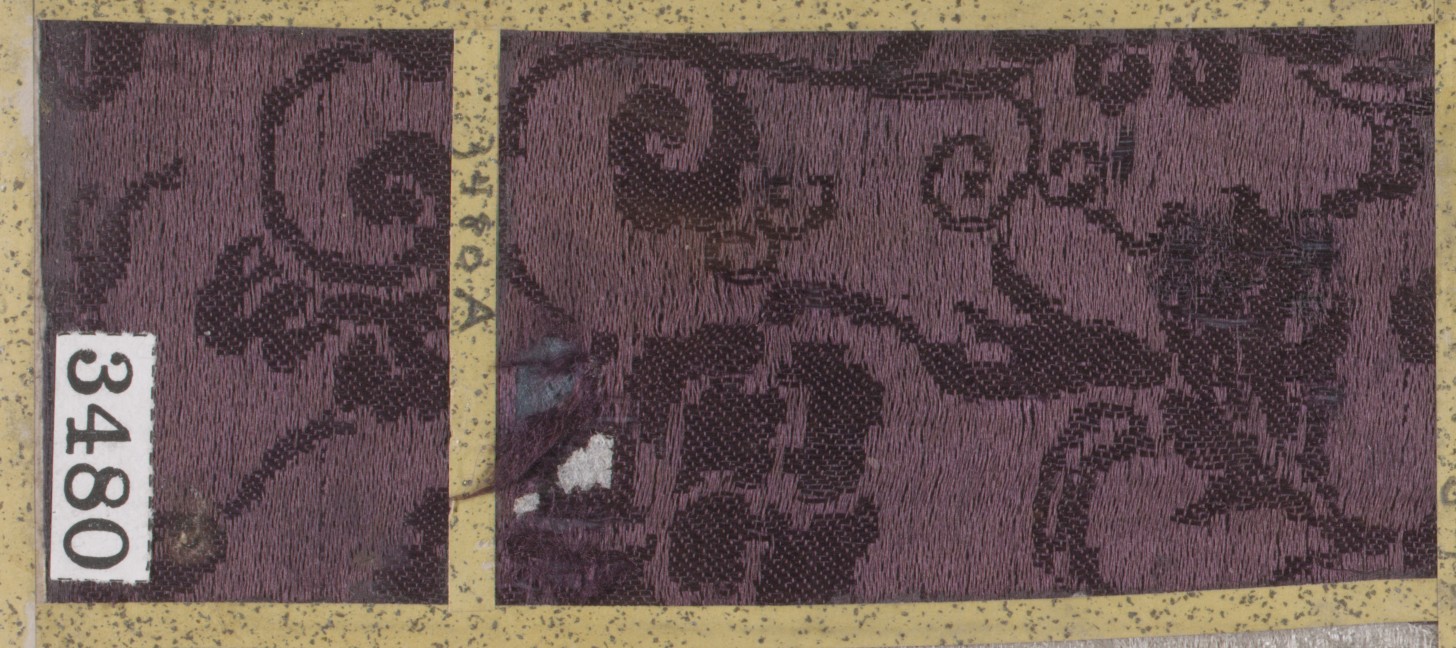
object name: sample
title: Textile Sample from Sample Book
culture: japanese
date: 1801-1900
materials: silk